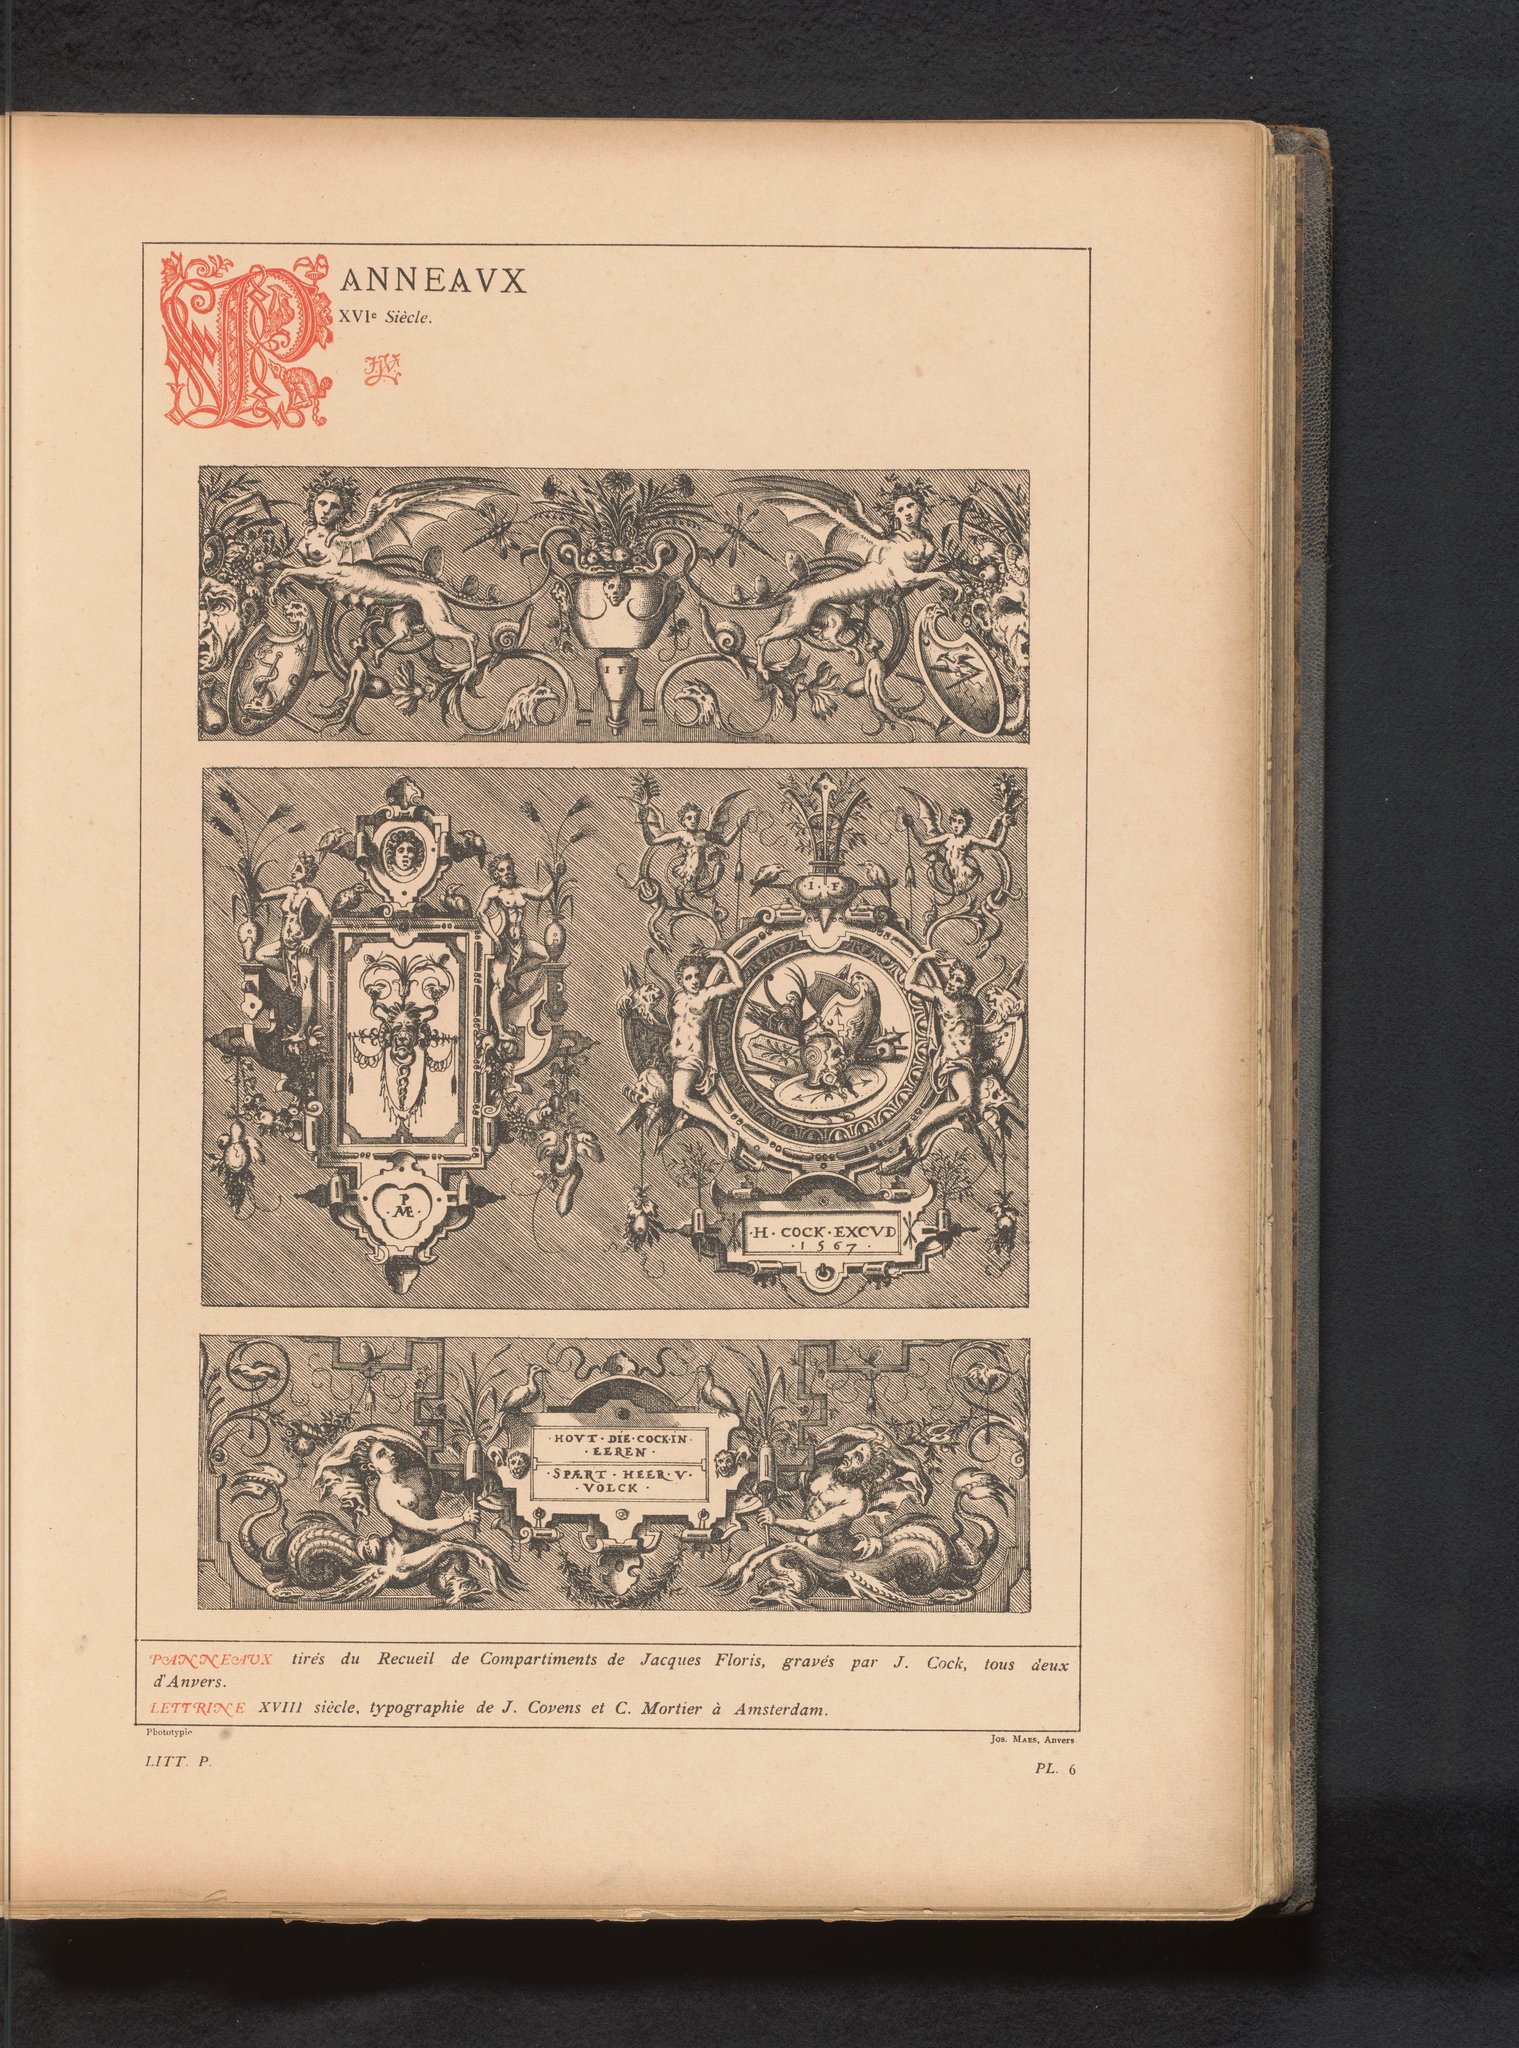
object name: photomechanical print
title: Reproductie van een prent van gedecoreerde panelen door Hieronymus Cock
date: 1876-1881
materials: paper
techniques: photolithography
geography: amsterdam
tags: fabulous animals ~ predatory animals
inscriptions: inscription: ‘LITT. P. - PL. 6.’, monogram: ‘JJvY’, inscription: ‘PANNEAUX tirés du (...)’